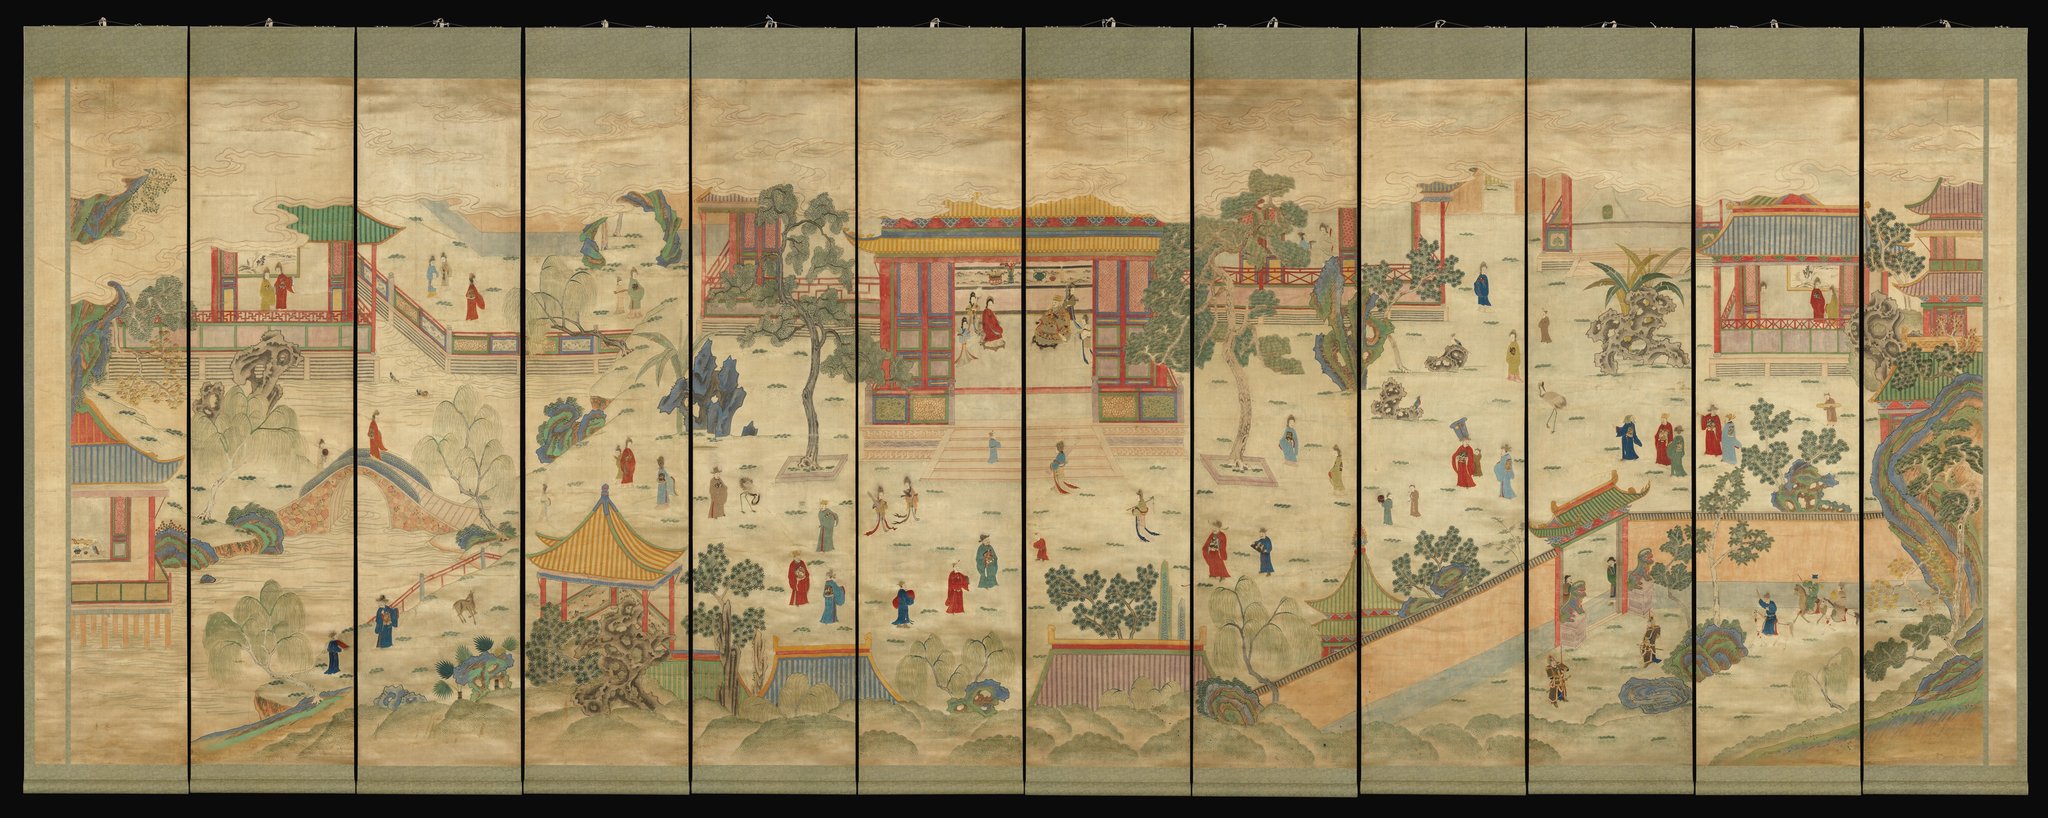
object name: hanging scroll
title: Celebratory scene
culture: chinese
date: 1601-1700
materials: paint, silk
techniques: embroidery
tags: birds,houses,men,women